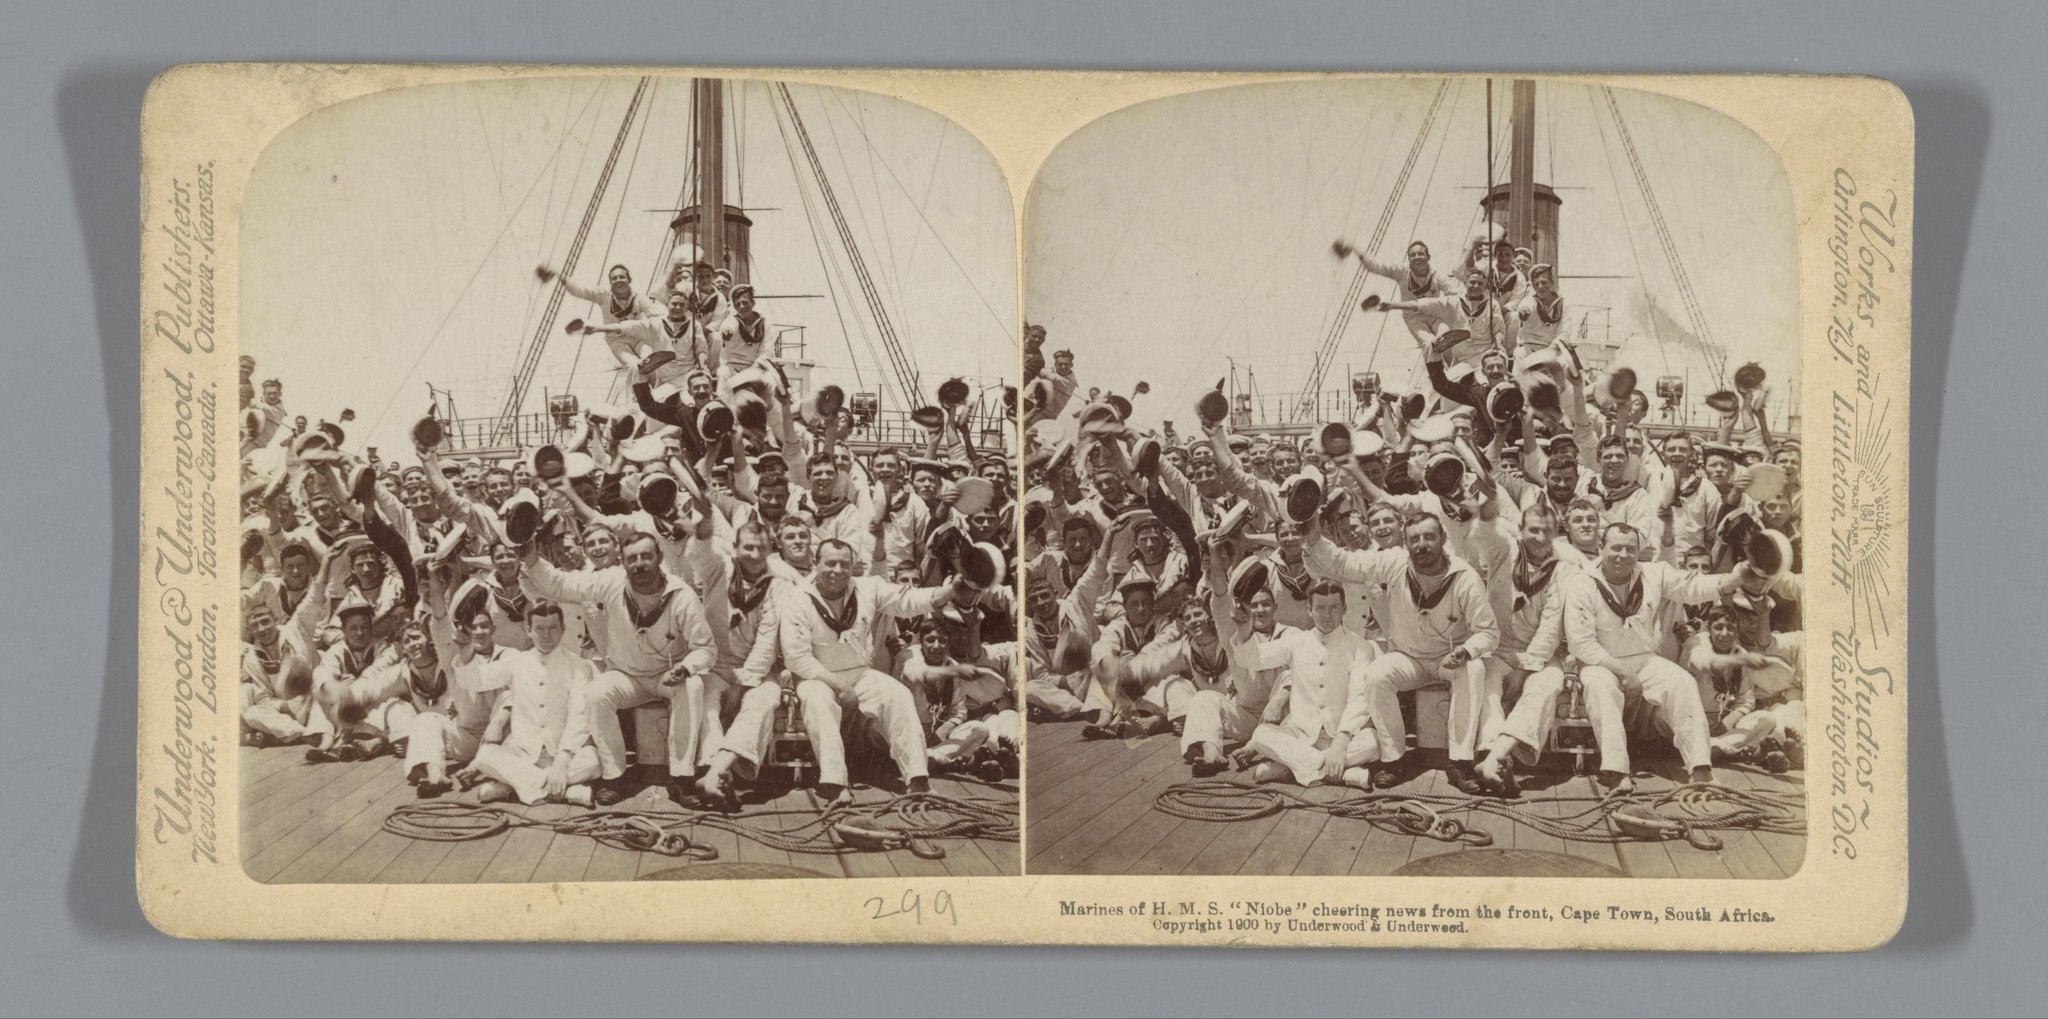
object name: stereograph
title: Marines of H.M.S. "Niobe" cheering news from the front, Cape Town, South Africa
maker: Anonymous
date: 1900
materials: cardboard, paper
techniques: albumen print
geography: cape town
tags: the company, the unit, the troop ~ military service (+marines)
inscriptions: inscription: ‘Works and Studios ~/ Arlington, N.J. Littleton, N.H. Washington, D.C.’, number: ‘299’, copyright notice: ‘Copyright 1900 by Underwood & Underwood.’, inscription